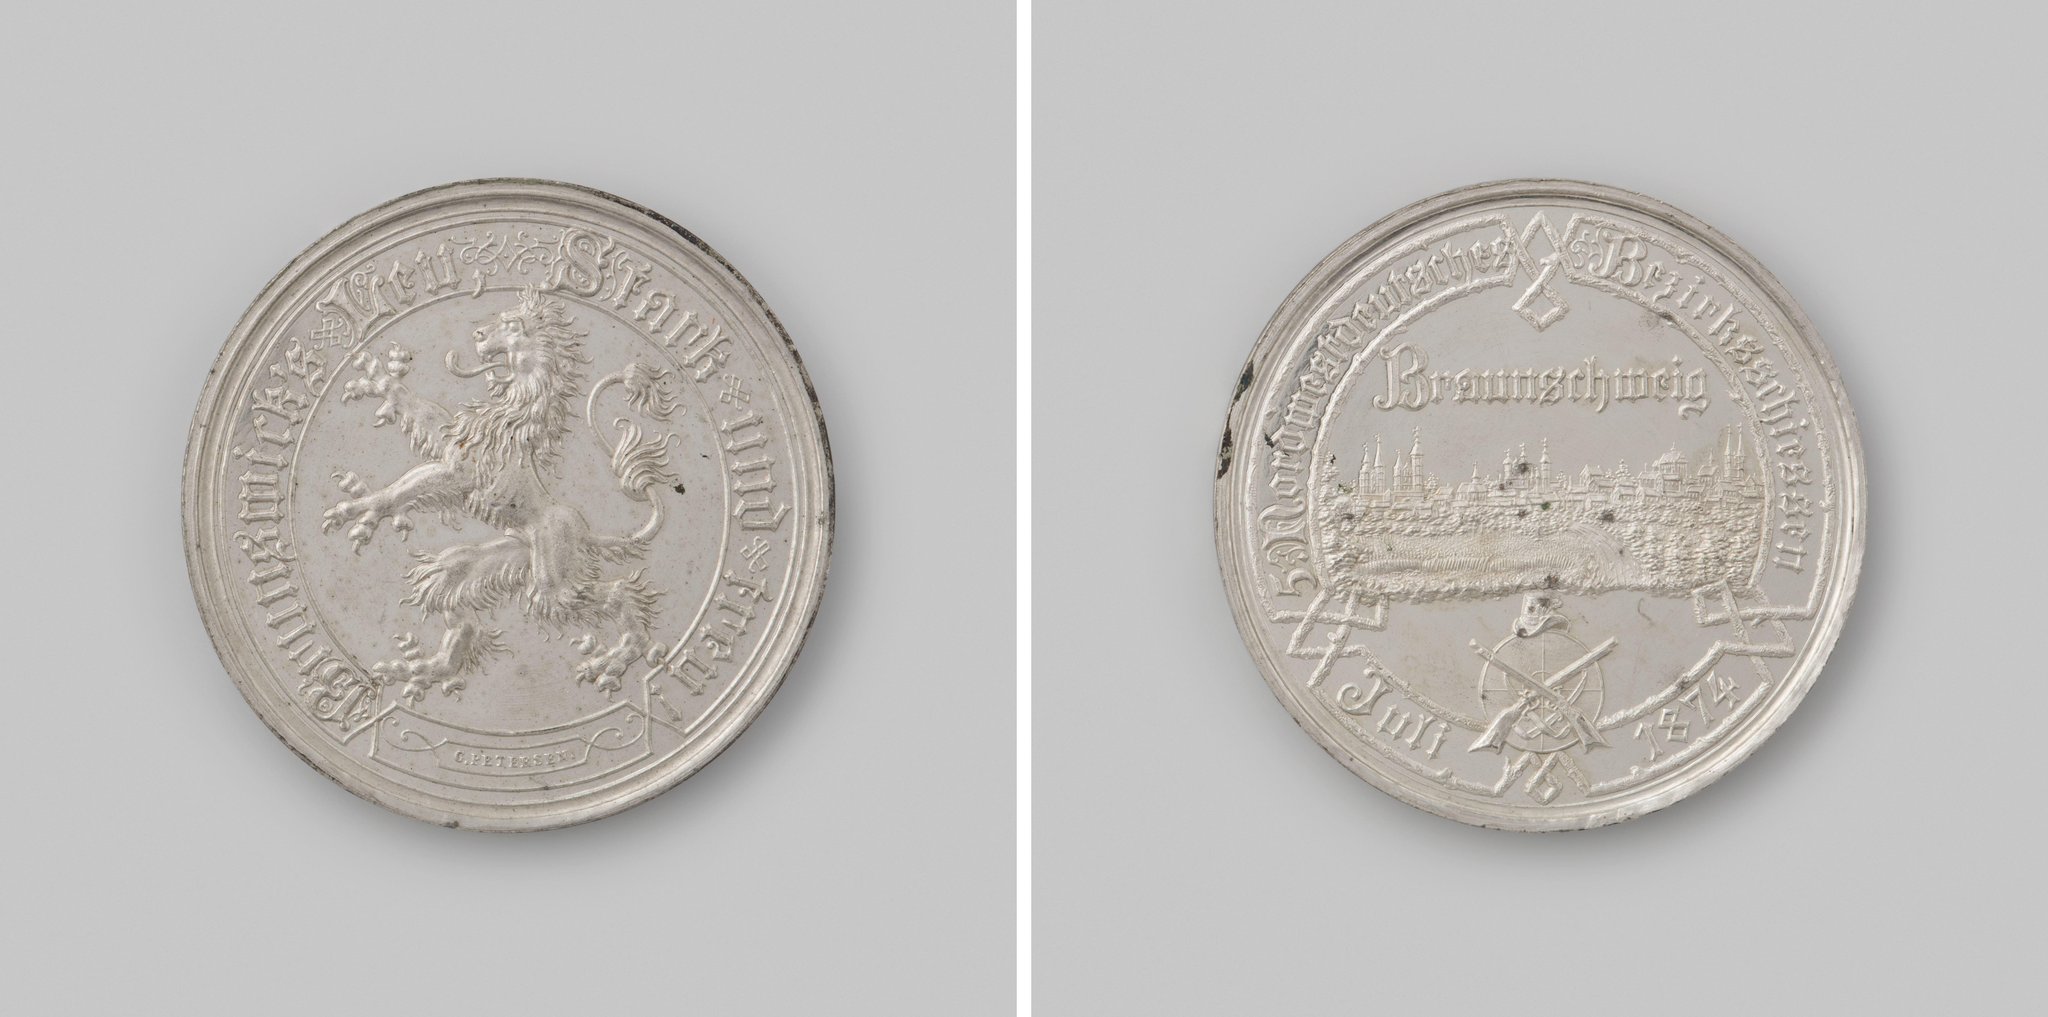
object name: history medal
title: Schietwedstrijd te Brunswijk 1874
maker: g. petersen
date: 1874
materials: tin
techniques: striking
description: Tinnen penning, op de voorzijde een klimmende leeuw naar links met omschrift, op de keerzijde het wedstrijdgebouw met één regel tekst en omschrift.